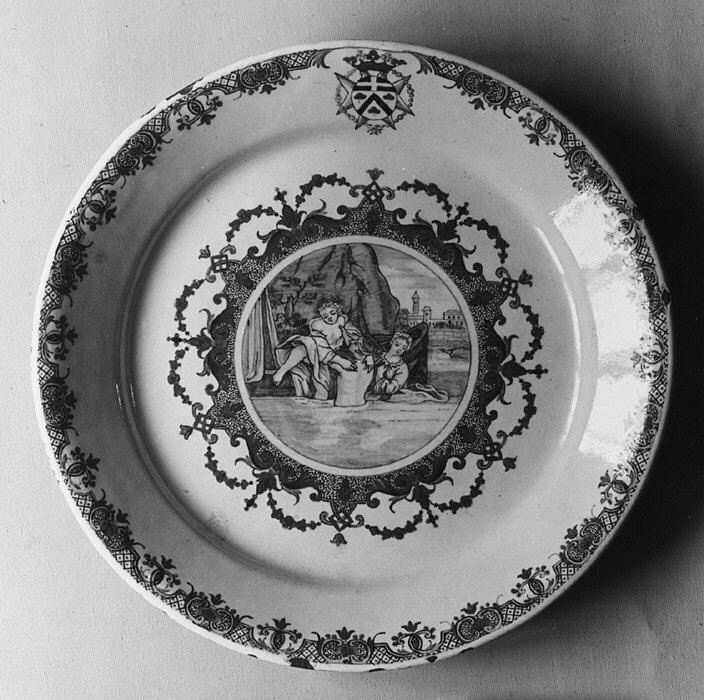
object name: plate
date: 1701-1800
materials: faience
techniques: glazing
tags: human figures,coat of arms